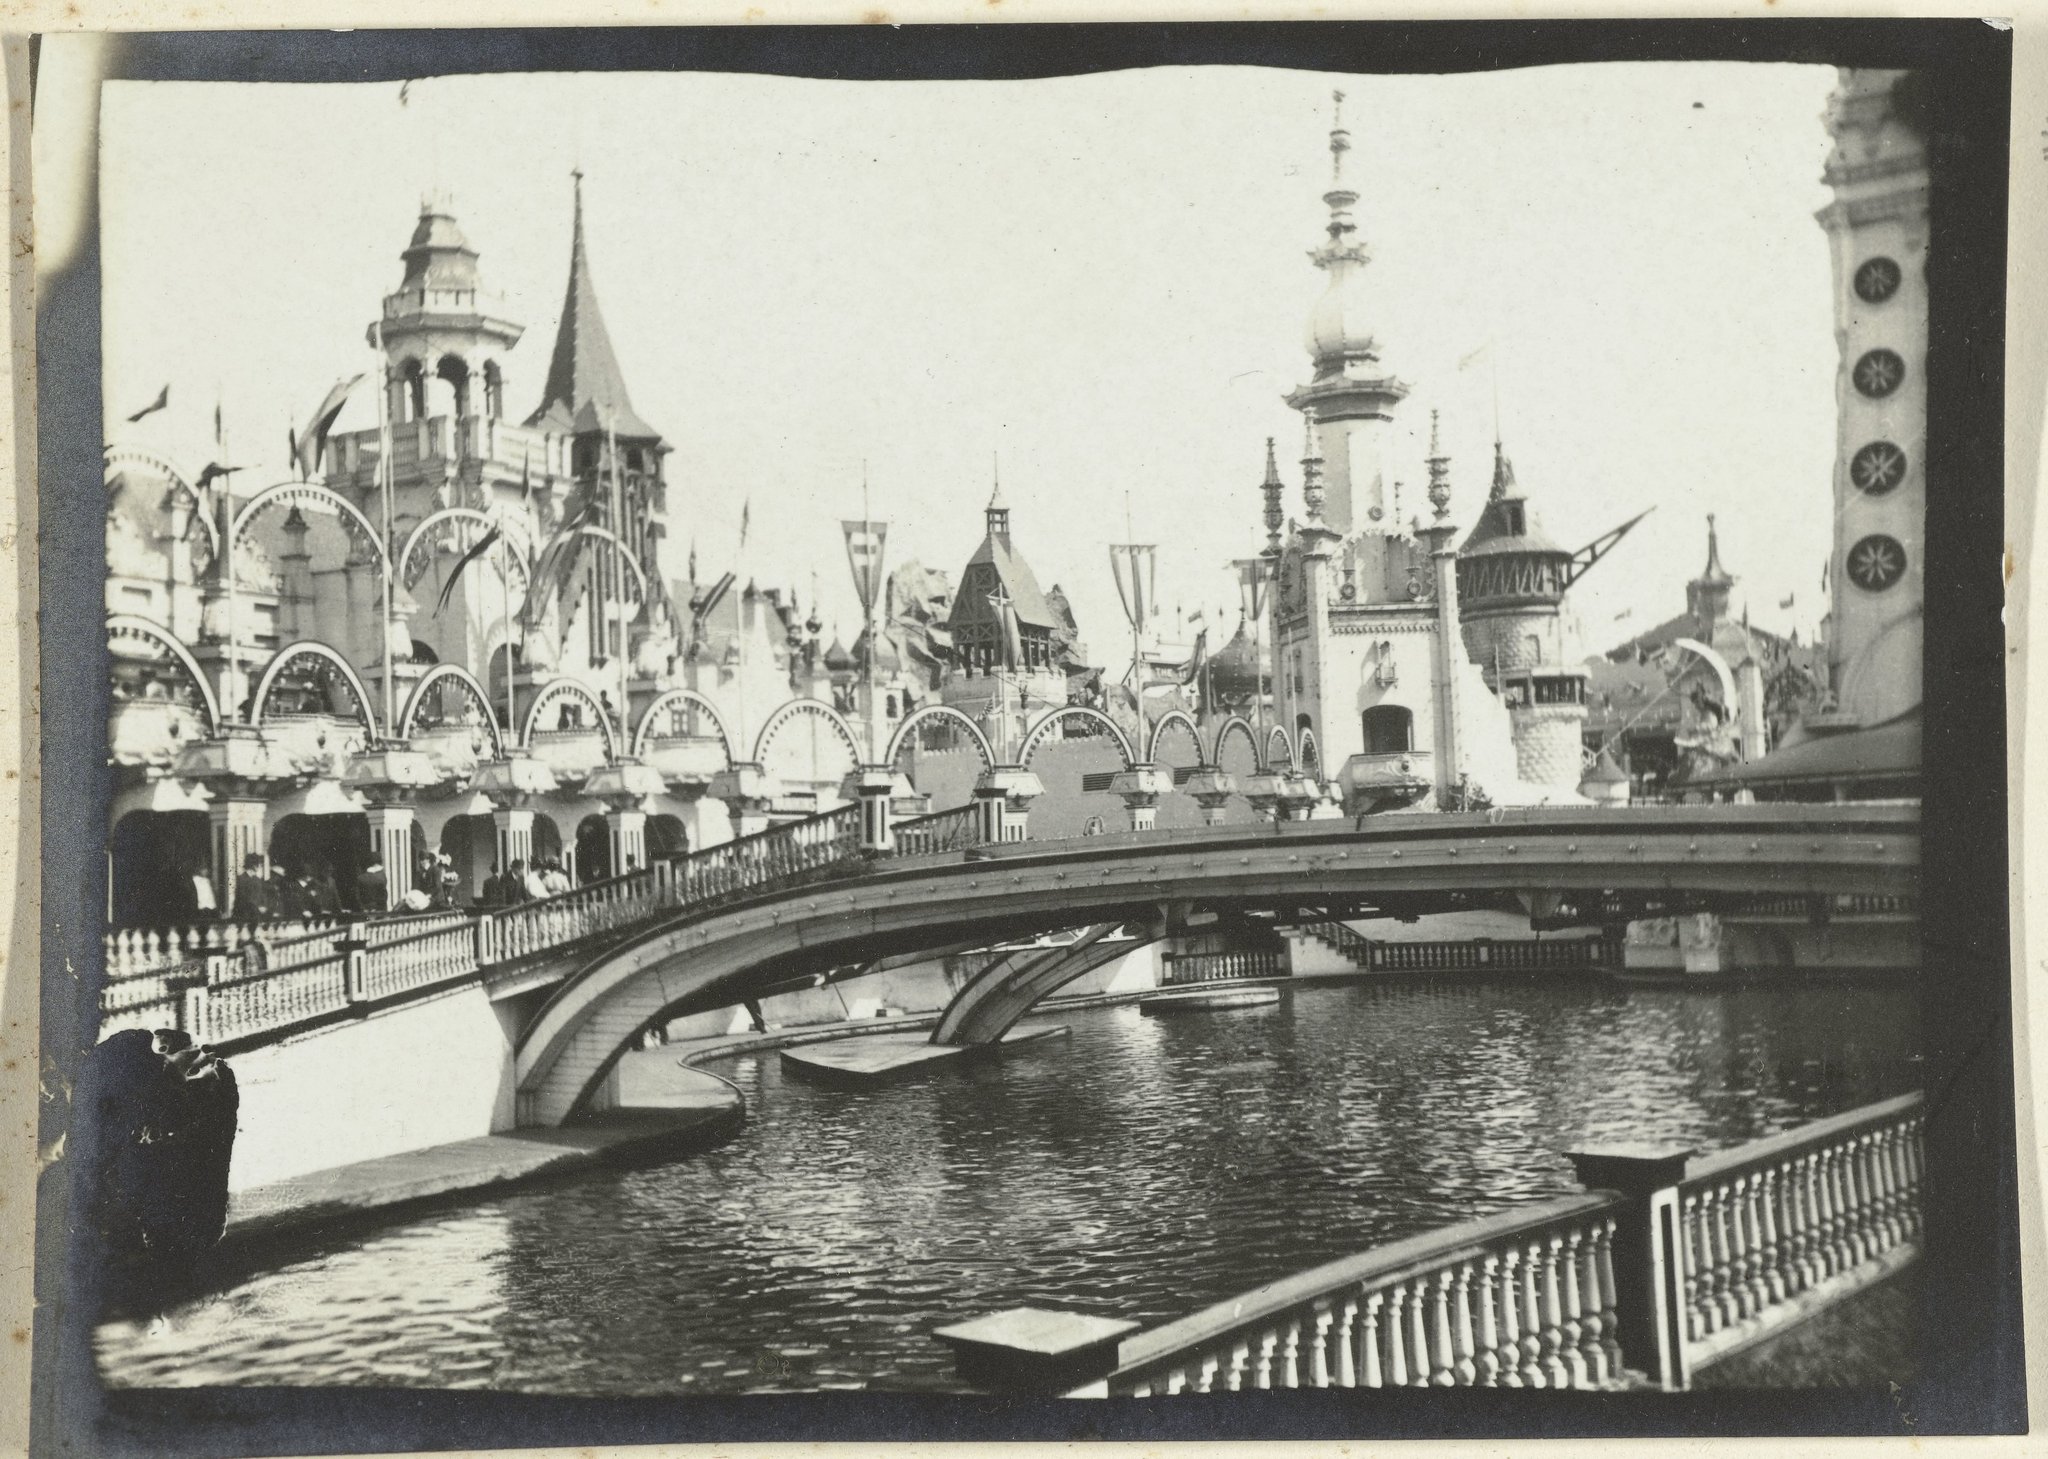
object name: photograph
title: Coney Island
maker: geldolph adriaan kessler (dolph)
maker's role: fotograaf, industrieel, voetballer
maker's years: 1884-1945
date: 1905-1908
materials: cardboard, photographic support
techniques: gelatin silver print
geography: new york city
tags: coney island (new york)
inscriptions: title: ‘Coney Island’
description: Gezicht op attractiepark Coney Island in New York. Onderdeel van het fotoalbum van Dolph Kessler met opnamen die hij maakte tijdens zijn verblijf in Engeland en op een wereldreis die hij als secretaris van Henri Deterding (directeur Koninklijke Olie) ondernam naar Nederlands-Indië, Japan, China en de Verenigde Staten, tussen 1906 en 1908.